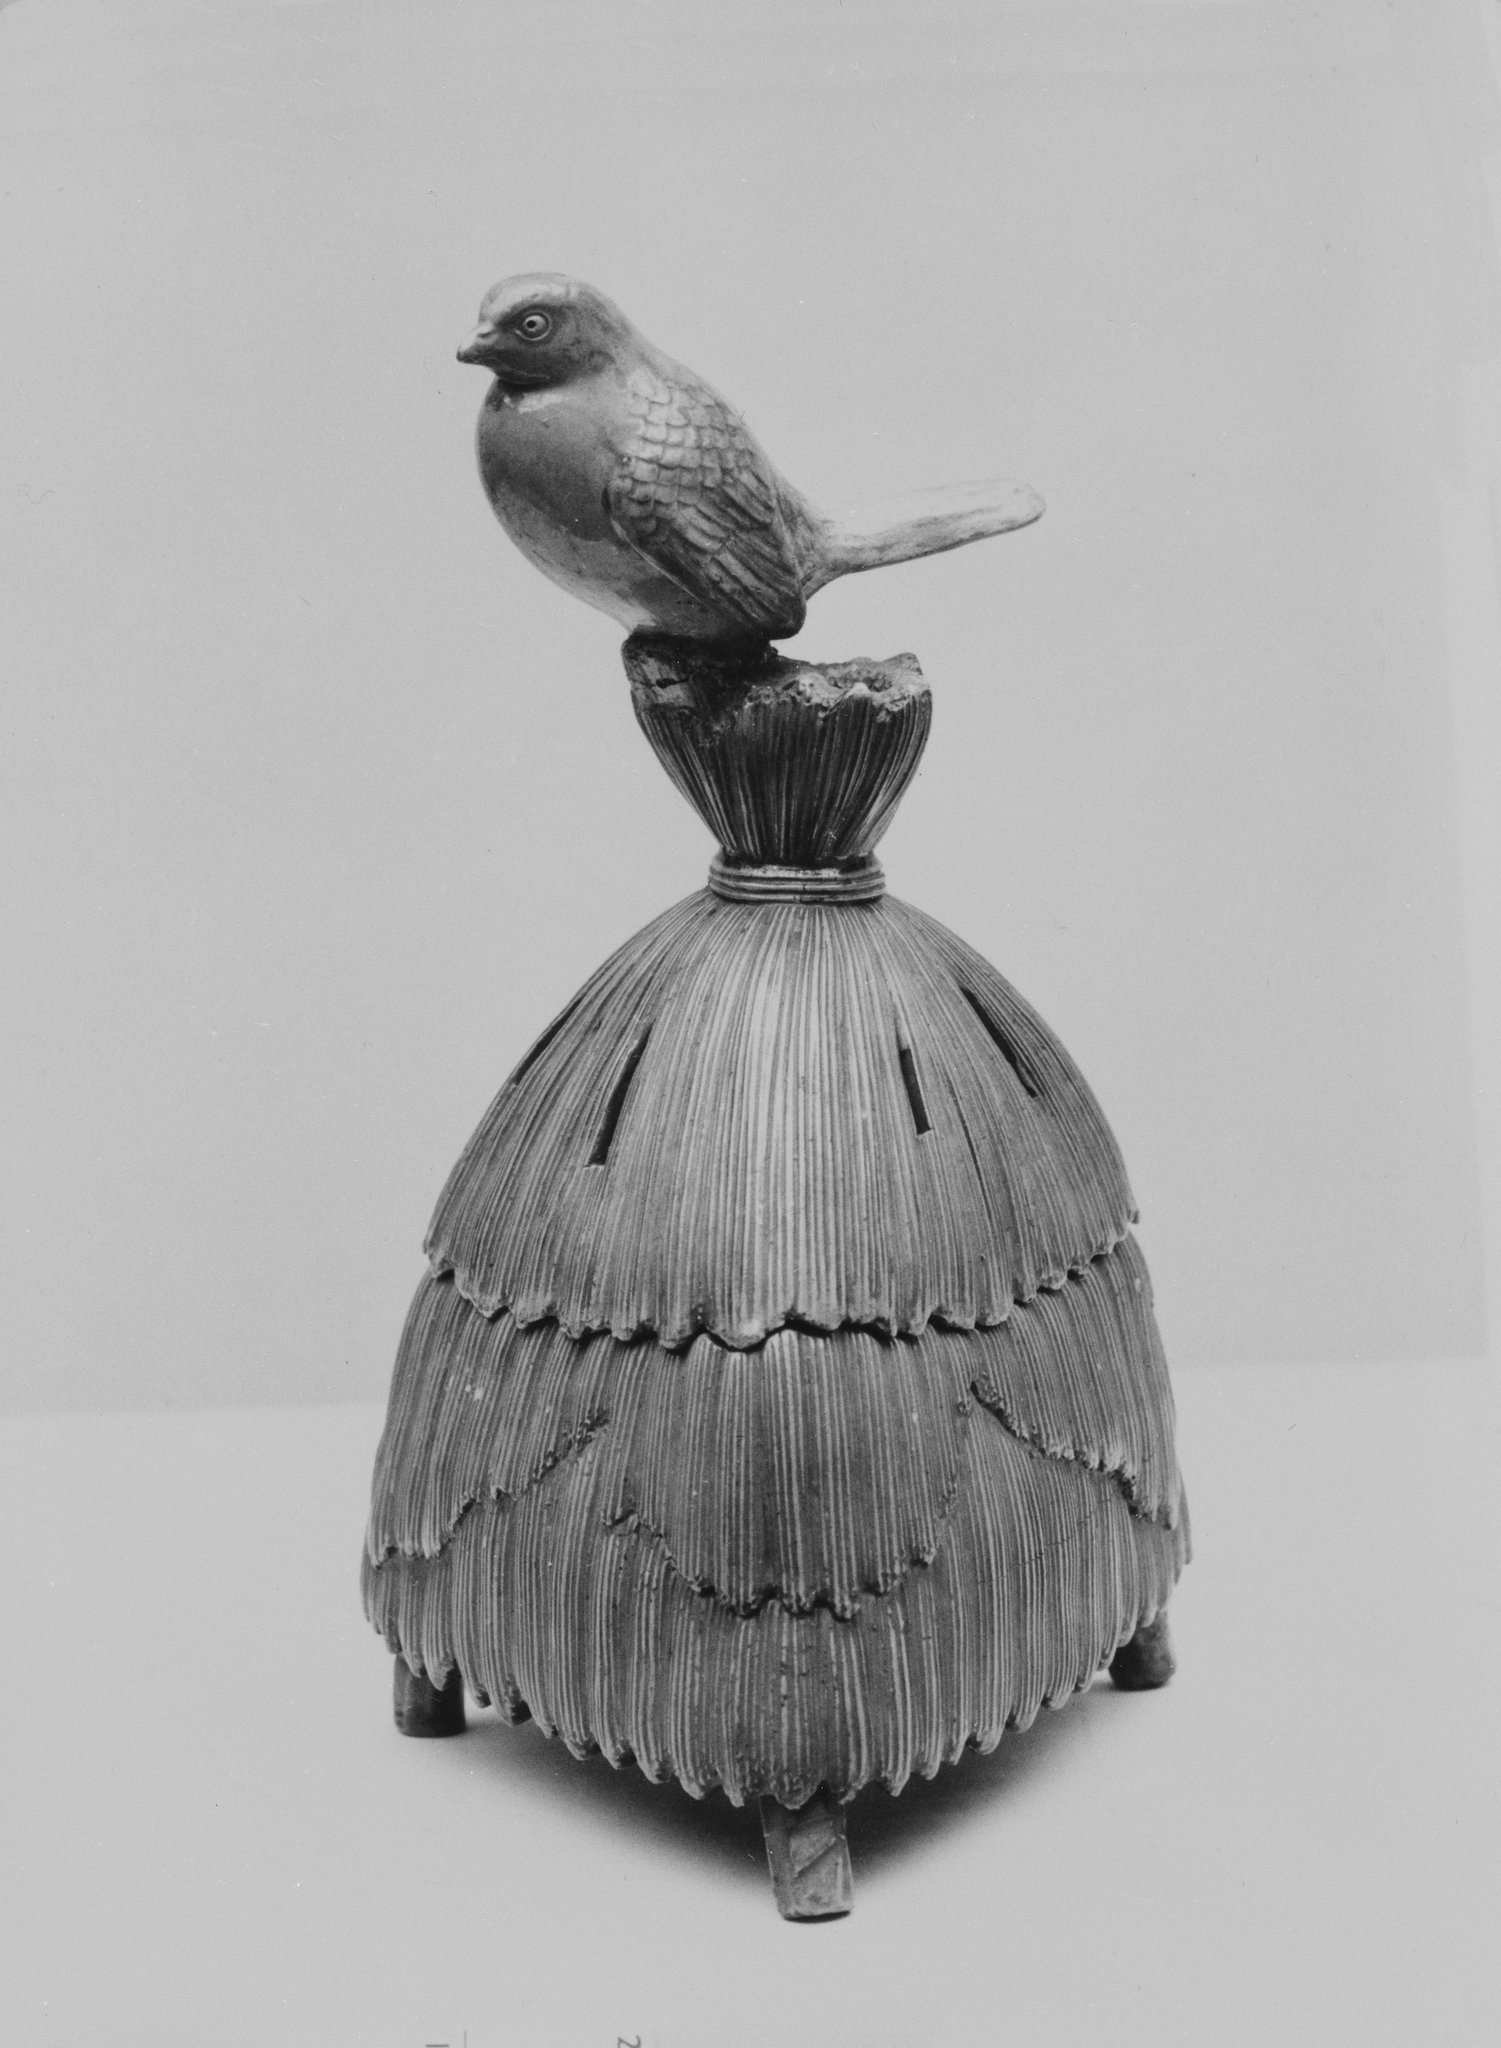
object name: censer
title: Censer in Form of a Sparrow Atop a Rice Rick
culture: japanese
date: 1700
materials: glaze, stoneware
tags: birds,censers